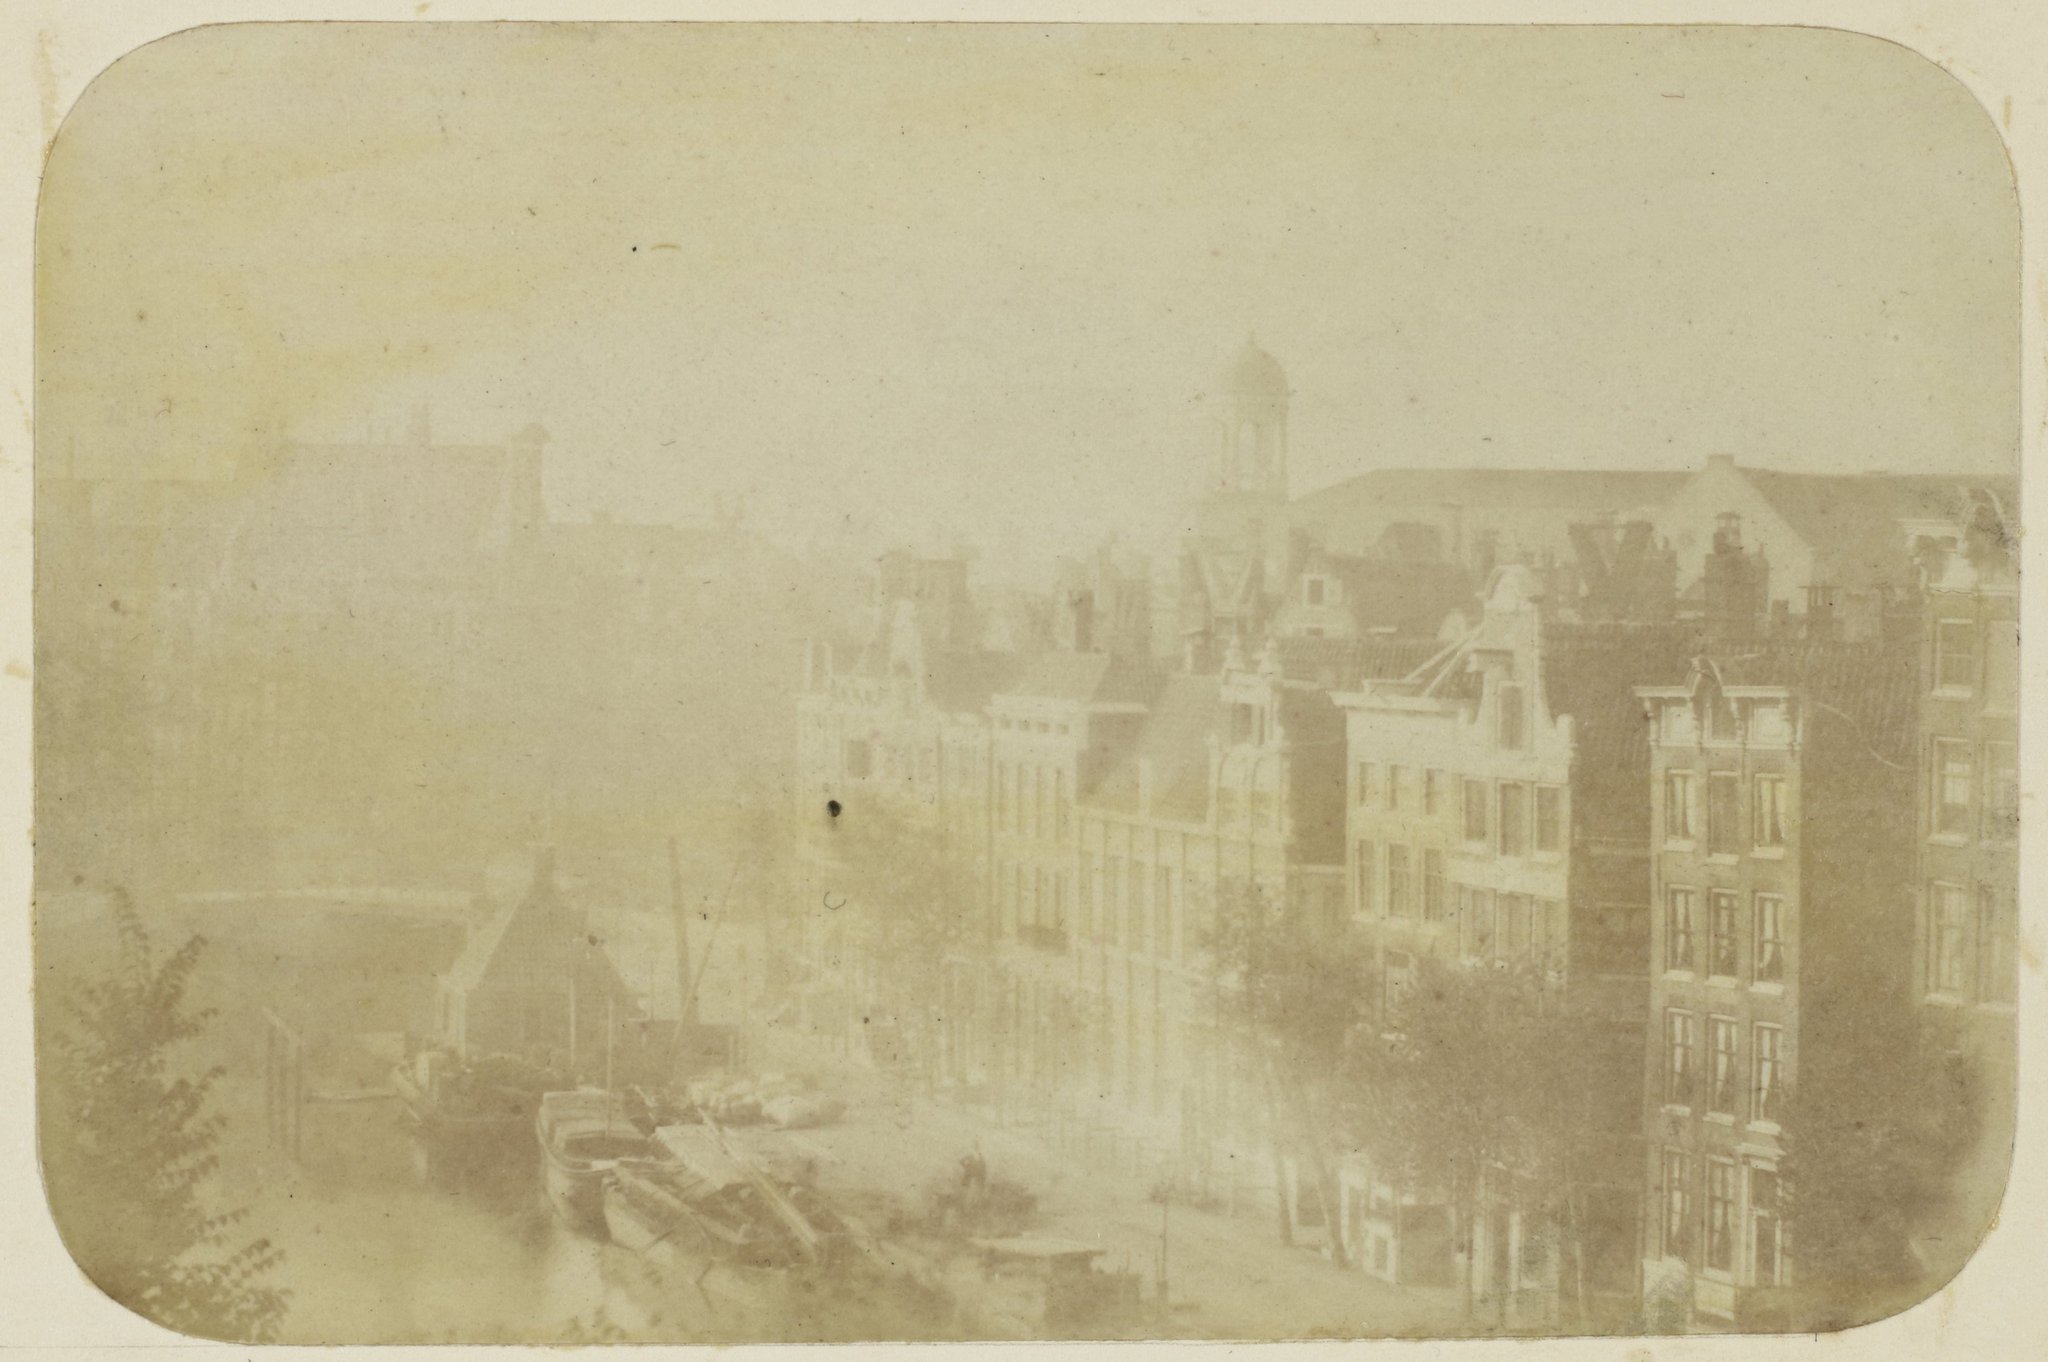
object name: photograph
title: Gezicht op de Catharinakerk en het Koningsplein in Amsterdam, gezien vanaf het dak van de fotograaf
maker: eduard isaac asser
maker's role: amateurfotograaf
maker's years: 1809-1894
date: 1852-1860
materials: cardboard, paper, photographic support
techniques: salted paper print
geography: amsterdam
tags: koningsplein, sint-catharinakerk